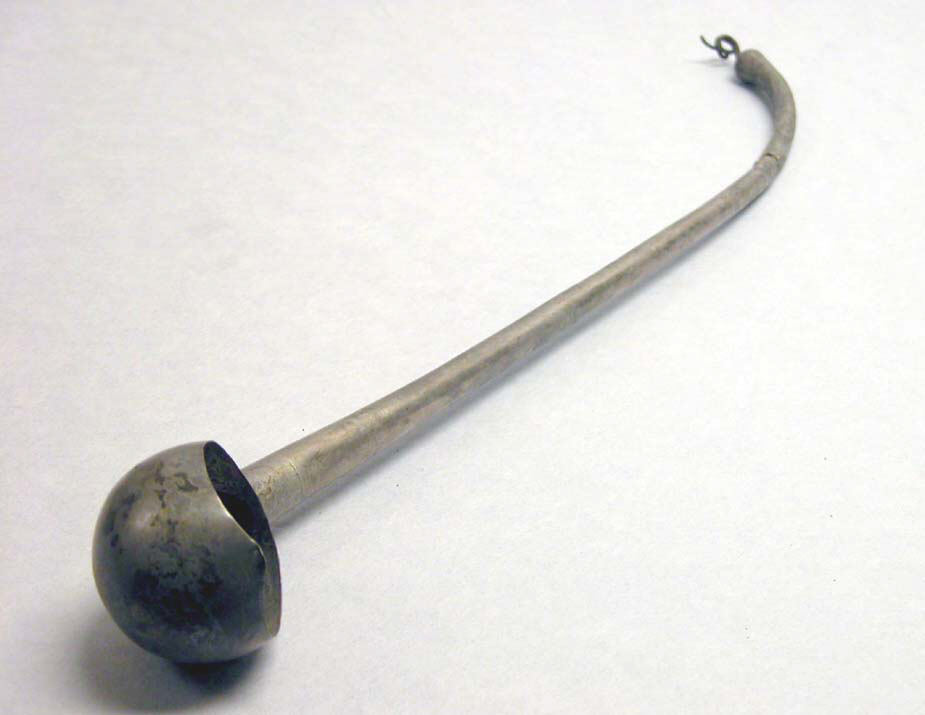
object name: ladle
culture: chinese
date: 618-907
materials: metal, silver